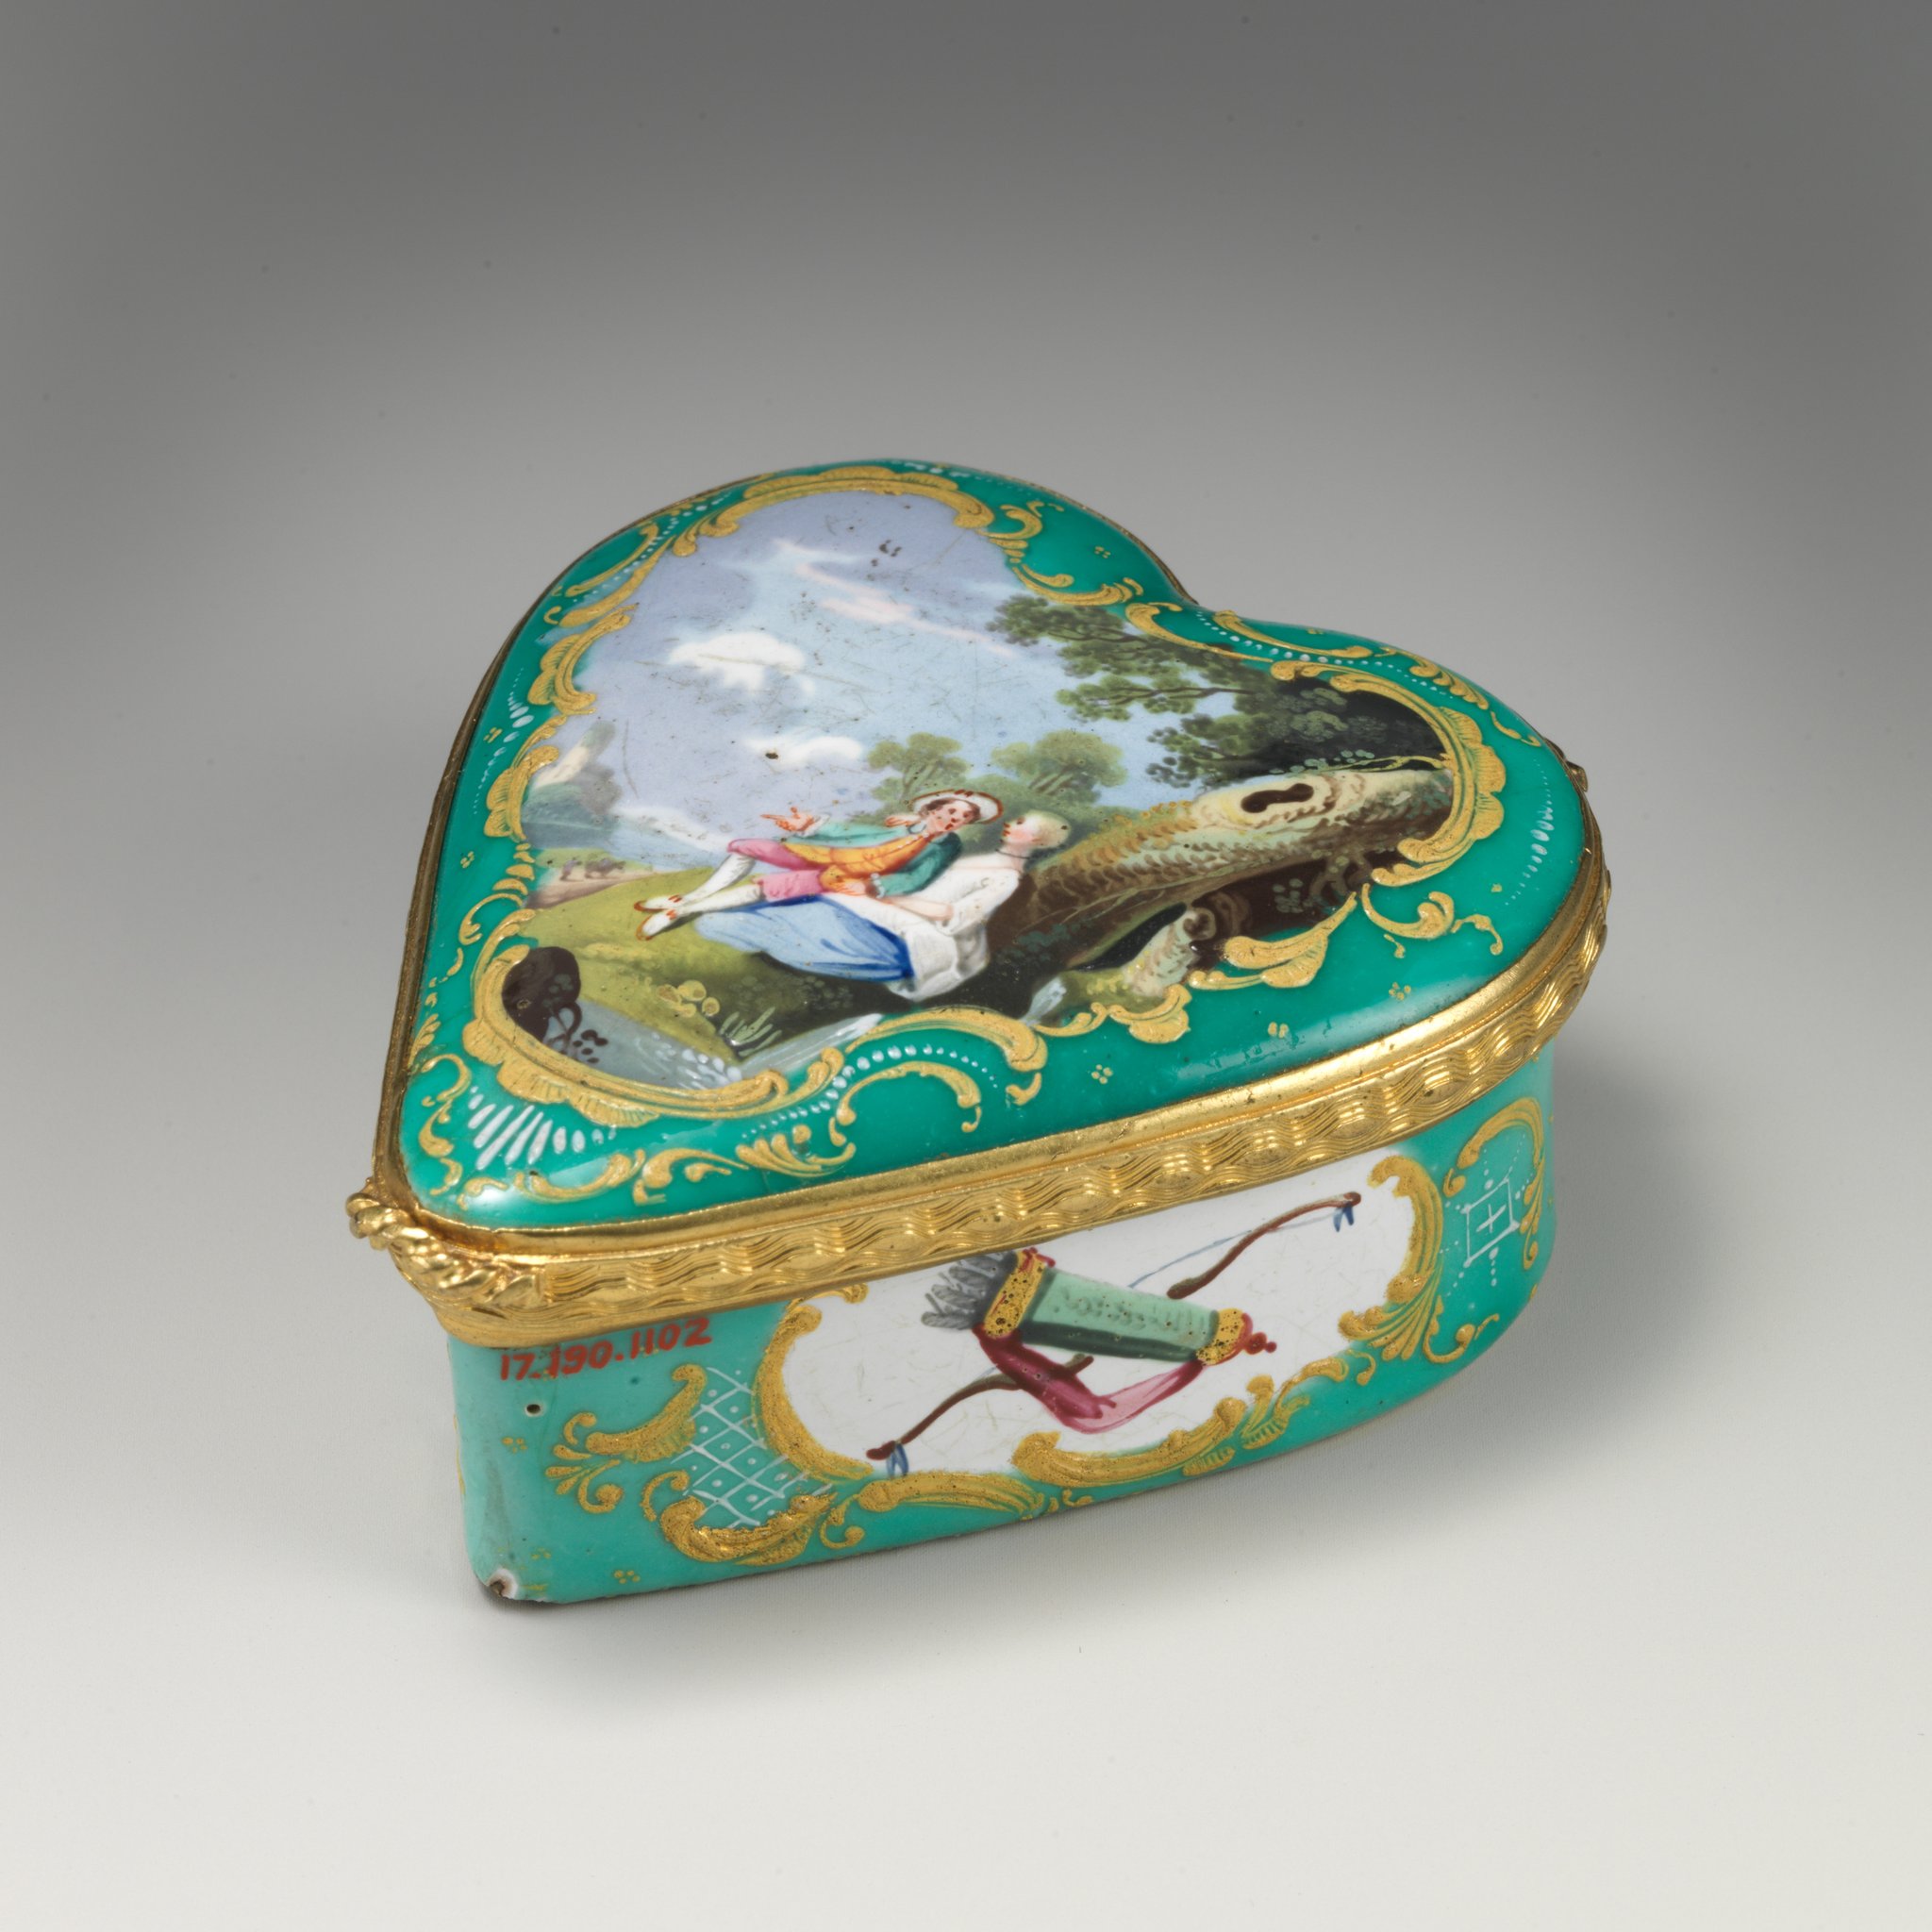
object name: snuffbox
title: Heart-shaped snuffbox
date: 1765-1770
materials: copper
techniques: enamel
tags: bow and arrow